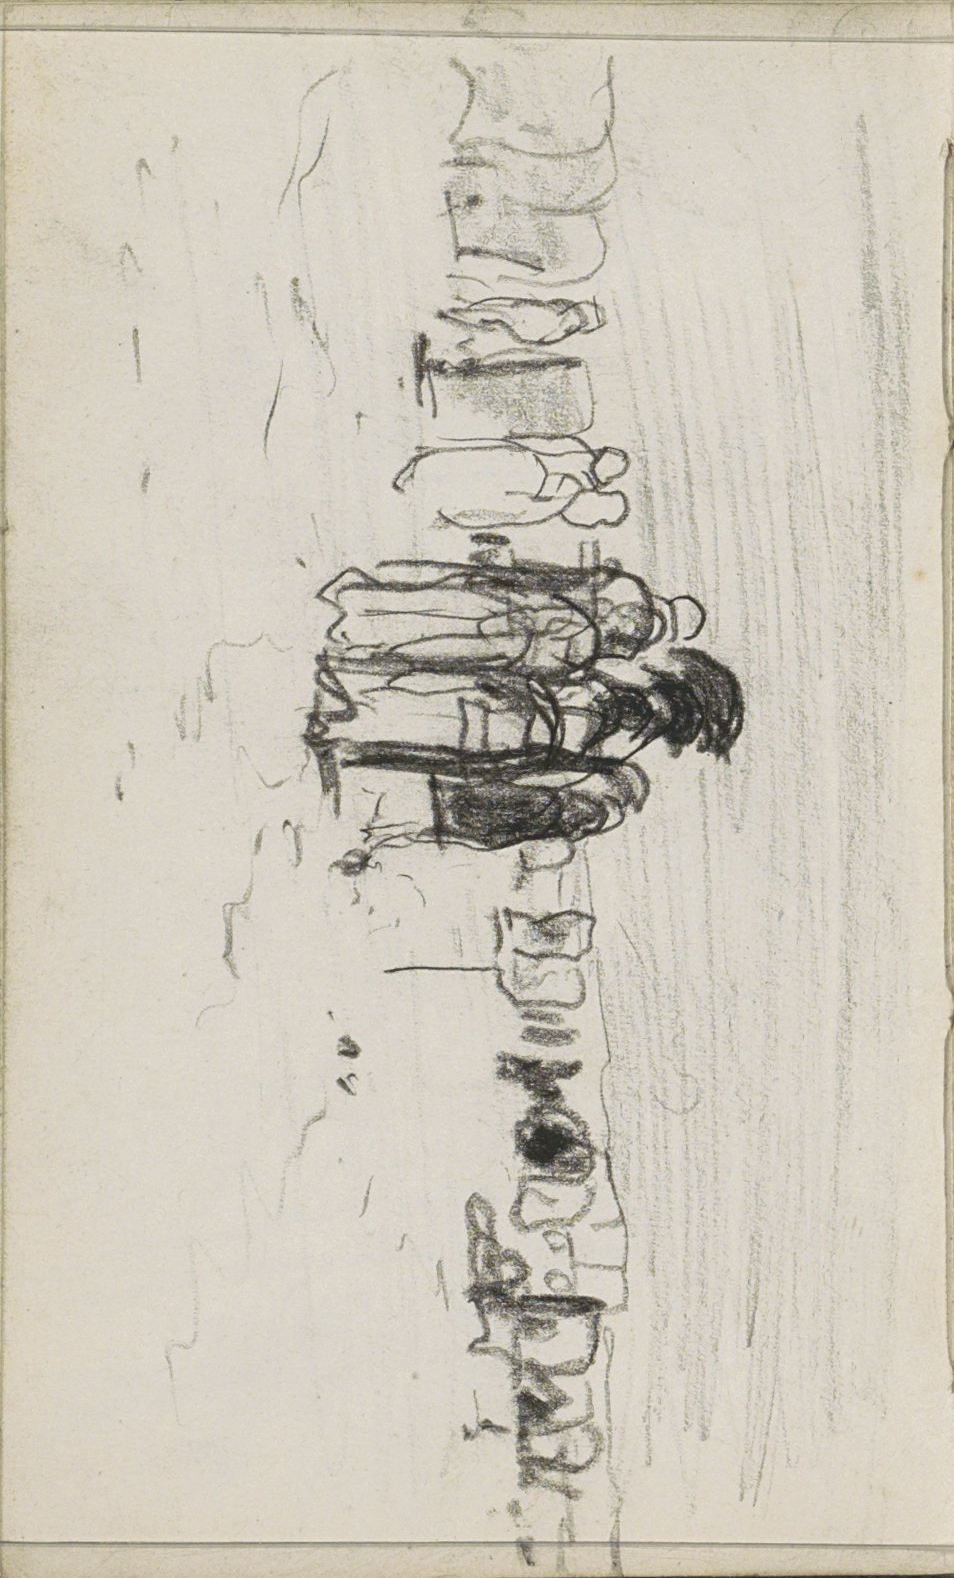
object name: sketchbook leaf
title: Korfstoelen en figuren op het strand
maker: anton mauve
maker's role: draughtsman, painter, print maker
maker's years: 1838-1888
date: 1848-1888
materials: chalk, paper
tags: beach (as place of recreation)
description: Blad 44 verso uit een schetsboek met 53 bladen.